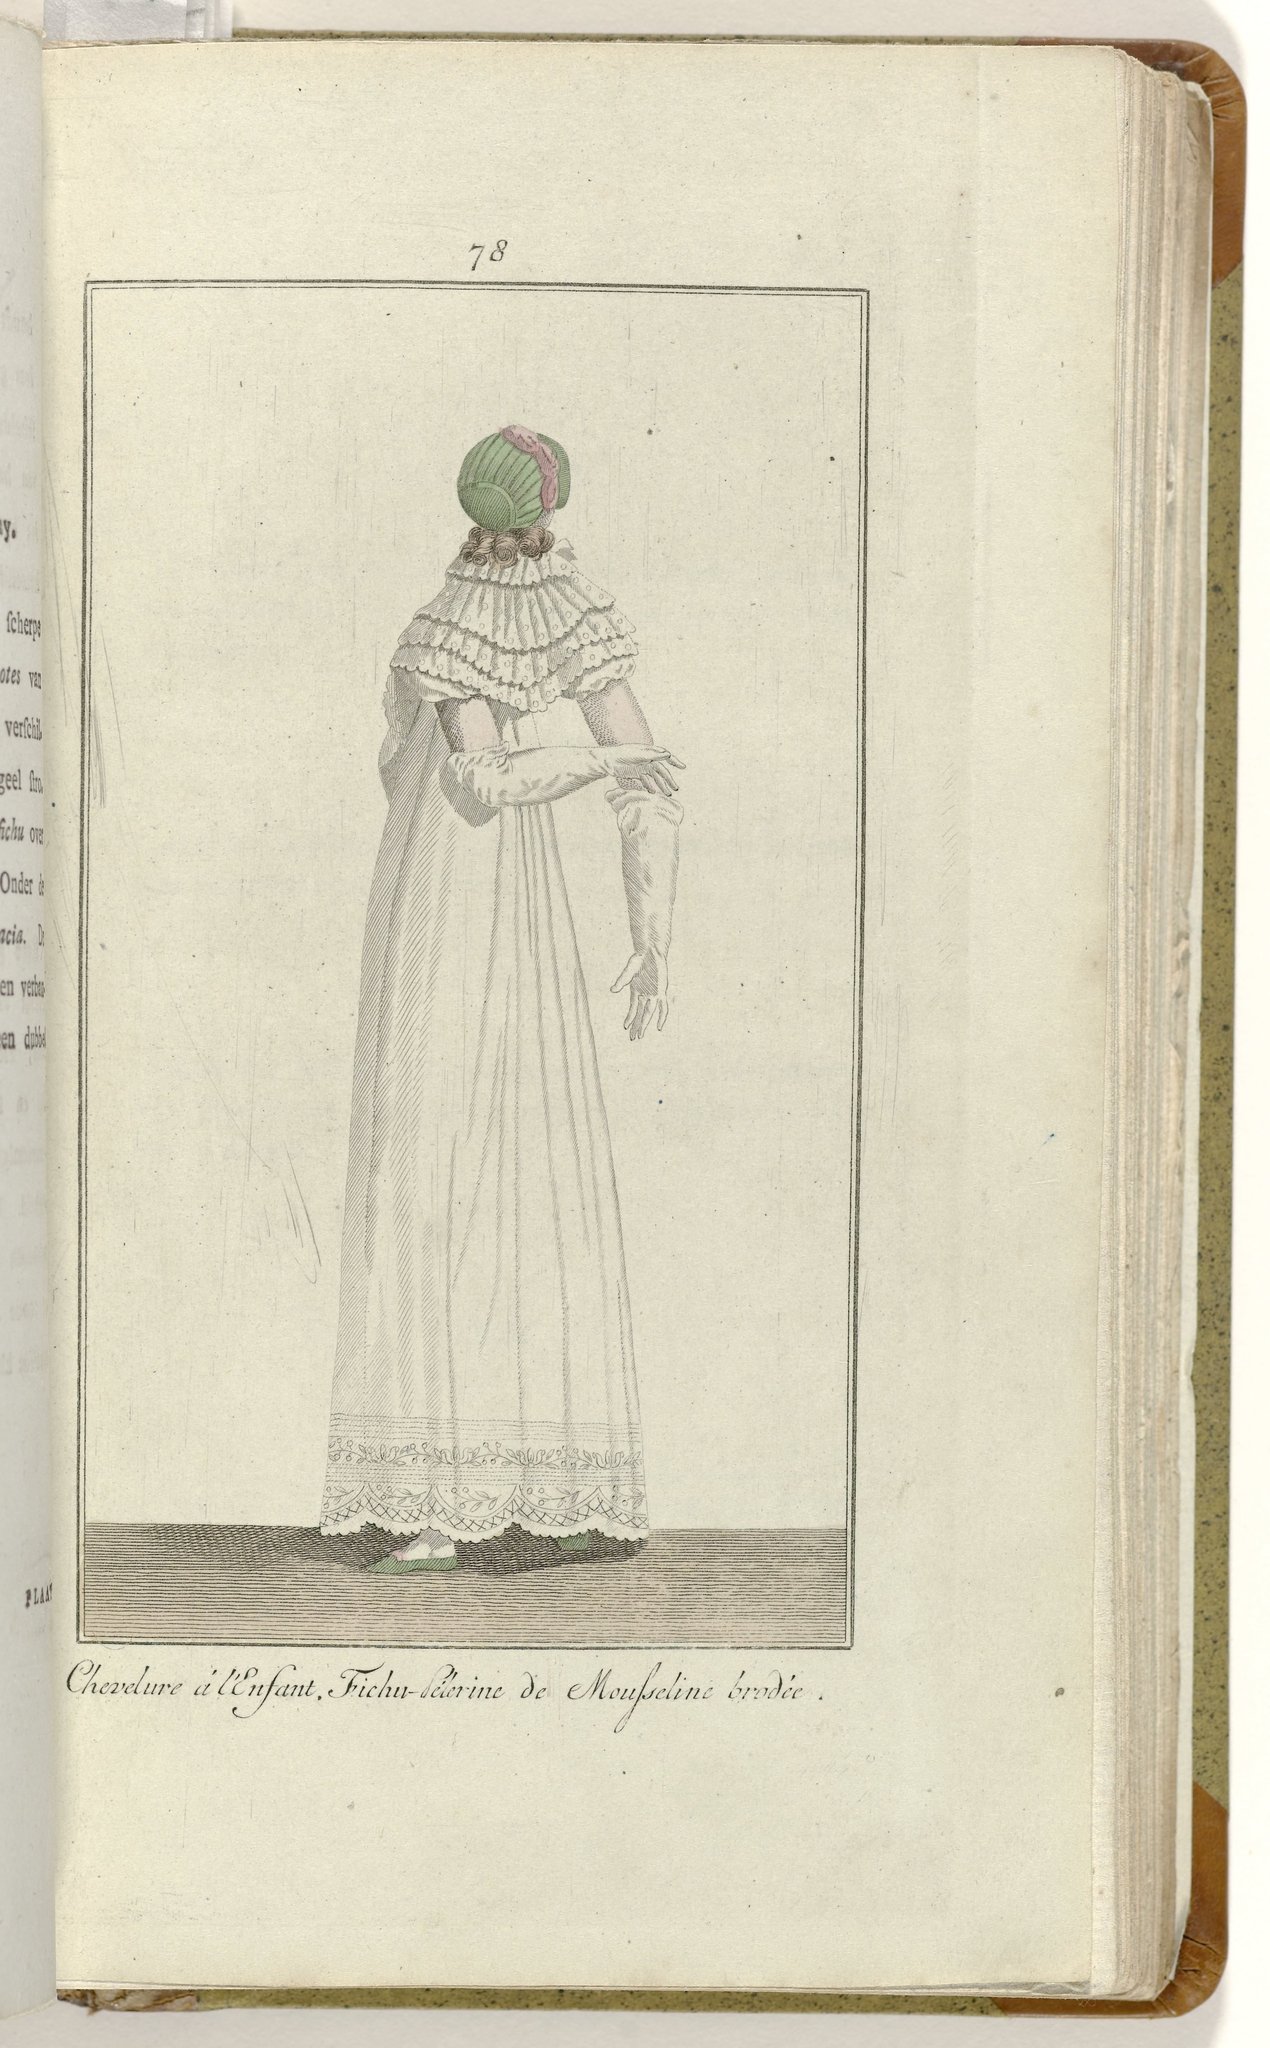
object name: fashion print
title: Elegantia, of tijdschrift van mode, luxe en smaak voor dames, Mei 1809, No. 78: Chevelure á l'Enfant...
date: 1809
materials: paper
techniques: engraving, hand coloring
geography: amsterdam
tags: head-gear (capote) (+ women's clothes), gloves, mittens (long gloves) (+ women's clothes), embroidery (ornamentation) (+ women's clothes), clothing for the upper part of the body (pelerine) (+ women's clothes), styles of hairdress - aa - ~ women, fashion plates, dress, gown (+ women's clothes), piece of clothing covering the breast or décolleté (fichu) (+ women's clothes)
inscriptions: caption: ‘Chevelure á l'Enfant, Fichu- Pélerine de Mousseline brodée.’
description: Volgens de begeleidende tekst (p. 159): Japon van katoenbatist (percale) met geborduurde rand. Fichu- pélérine' van geborduurde mousseline. 'Coëffure à l'enfant'; capote van groene zijde. Prent uit het modetijdschrift Elegantia, of tijdschrift van mode, luxe en smaak voor dames 1807-1814 (onderbroken door de periode 1811-1813).